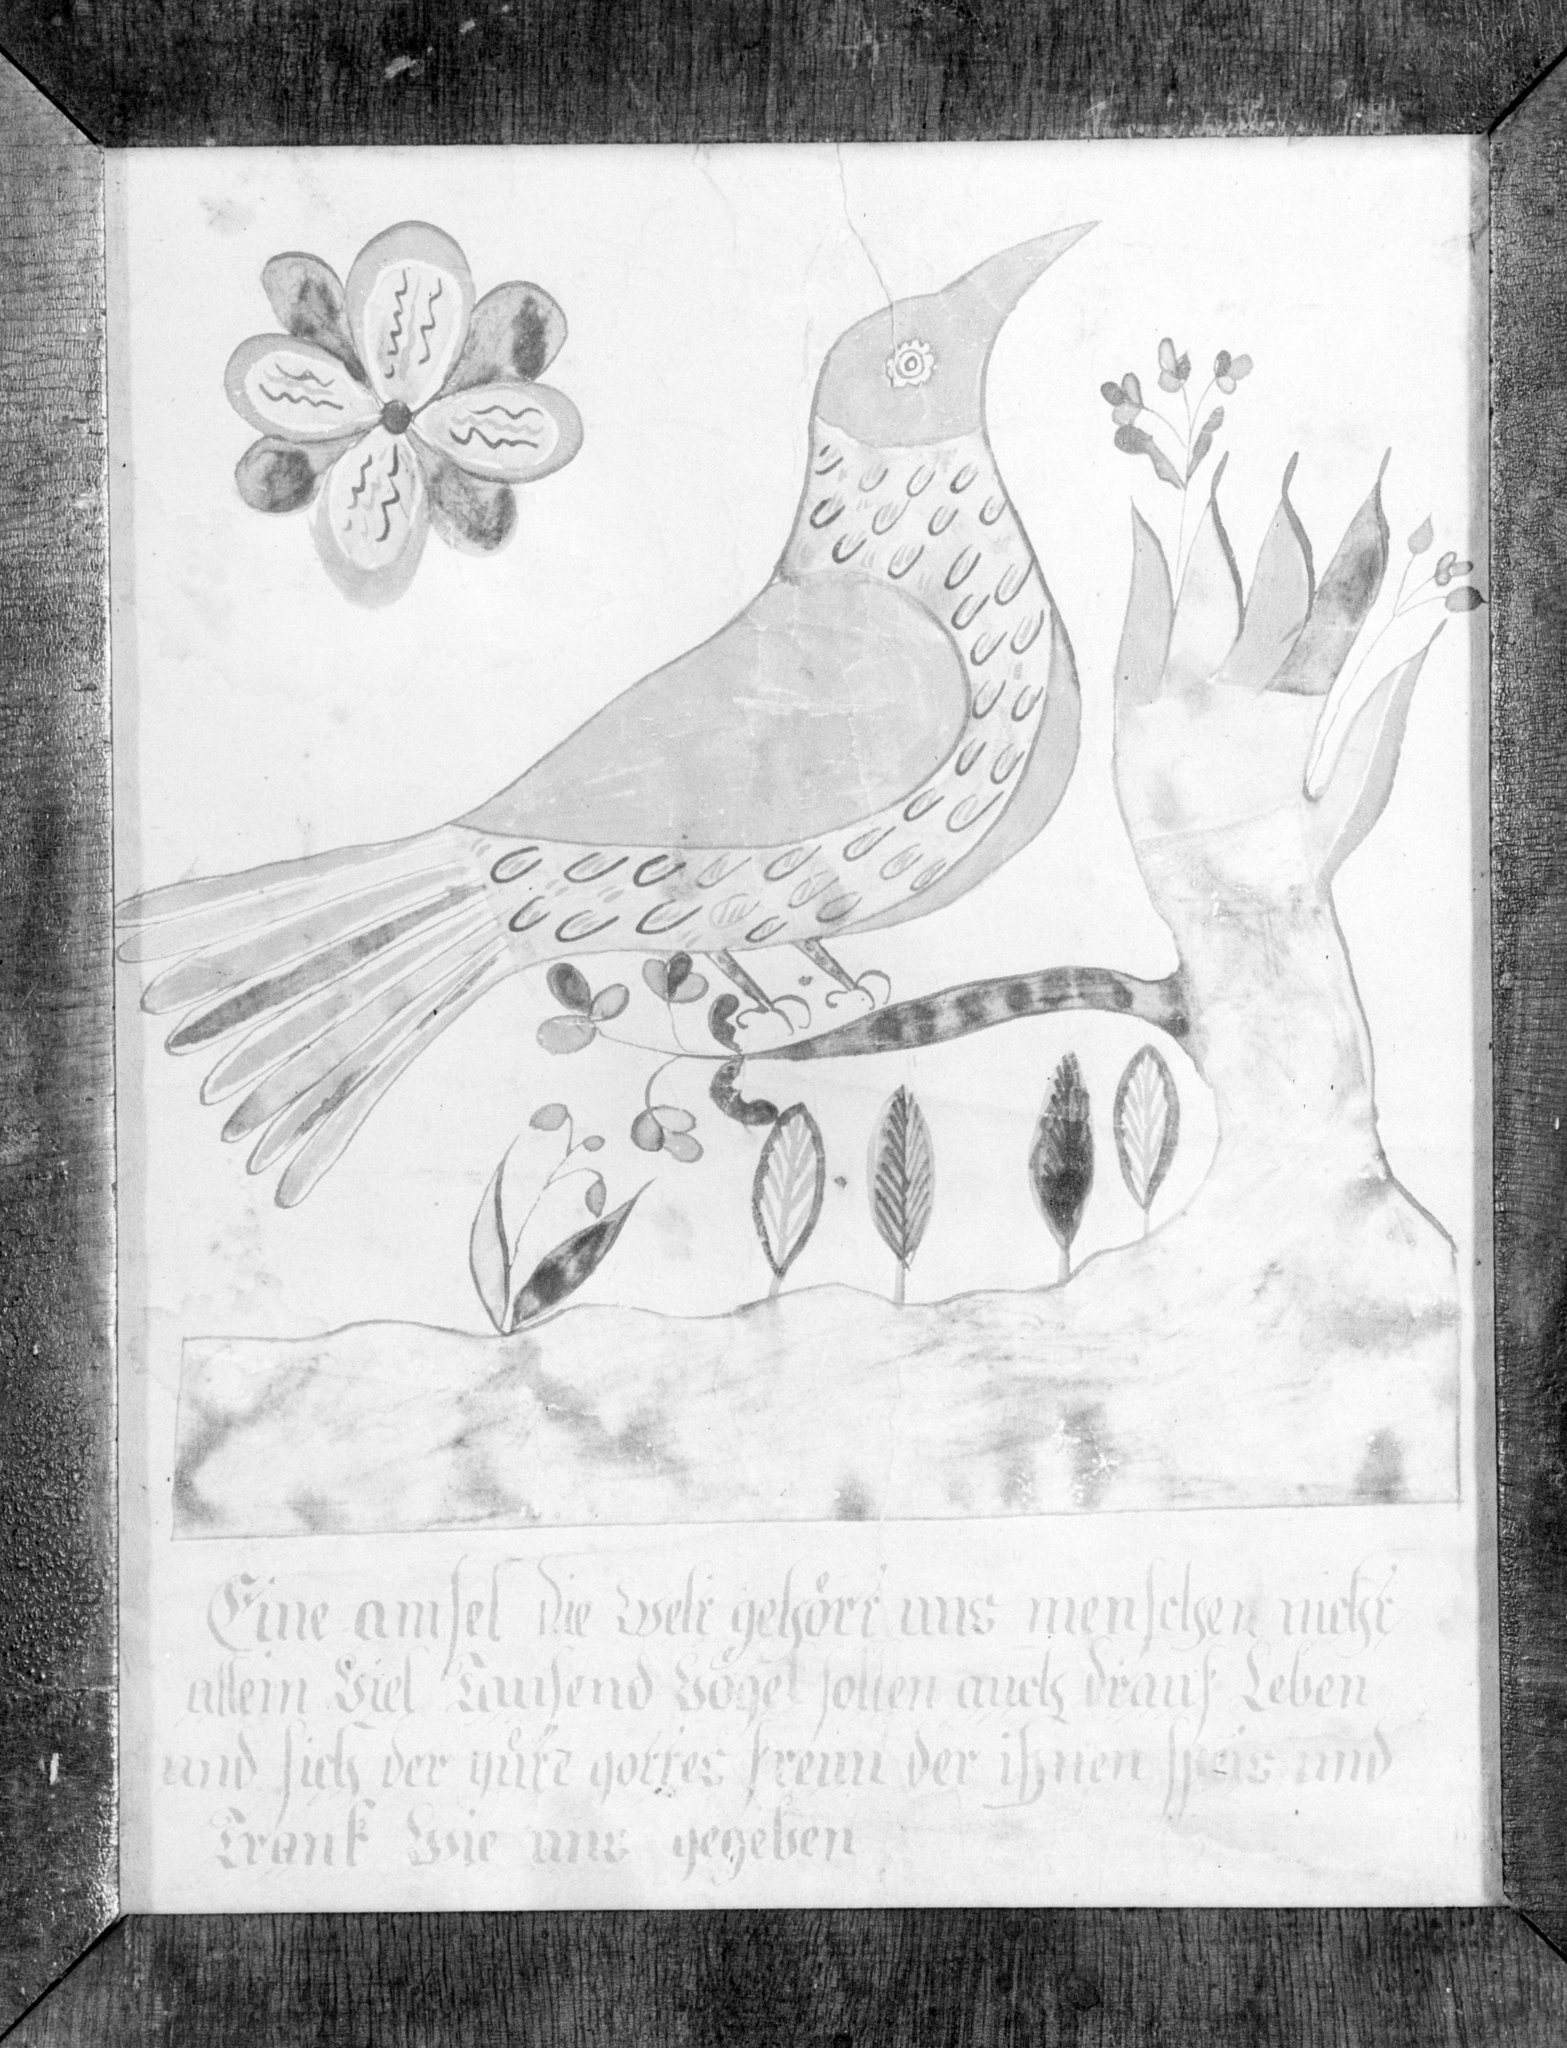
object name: drawing, fraktur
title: Drawing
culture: american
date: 1800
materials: paper, watercolor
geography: united states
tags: birds,flowers